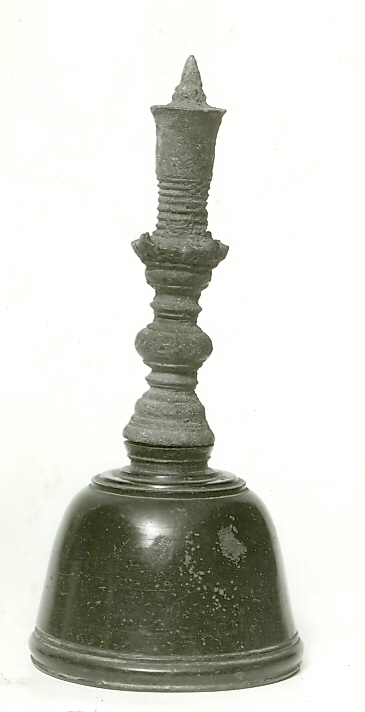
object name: gheṇṭa prayer bell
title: Gheṇṭa (prayer bell)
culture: javanese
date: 1001-1100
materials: bronze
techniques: casting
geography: indonesia